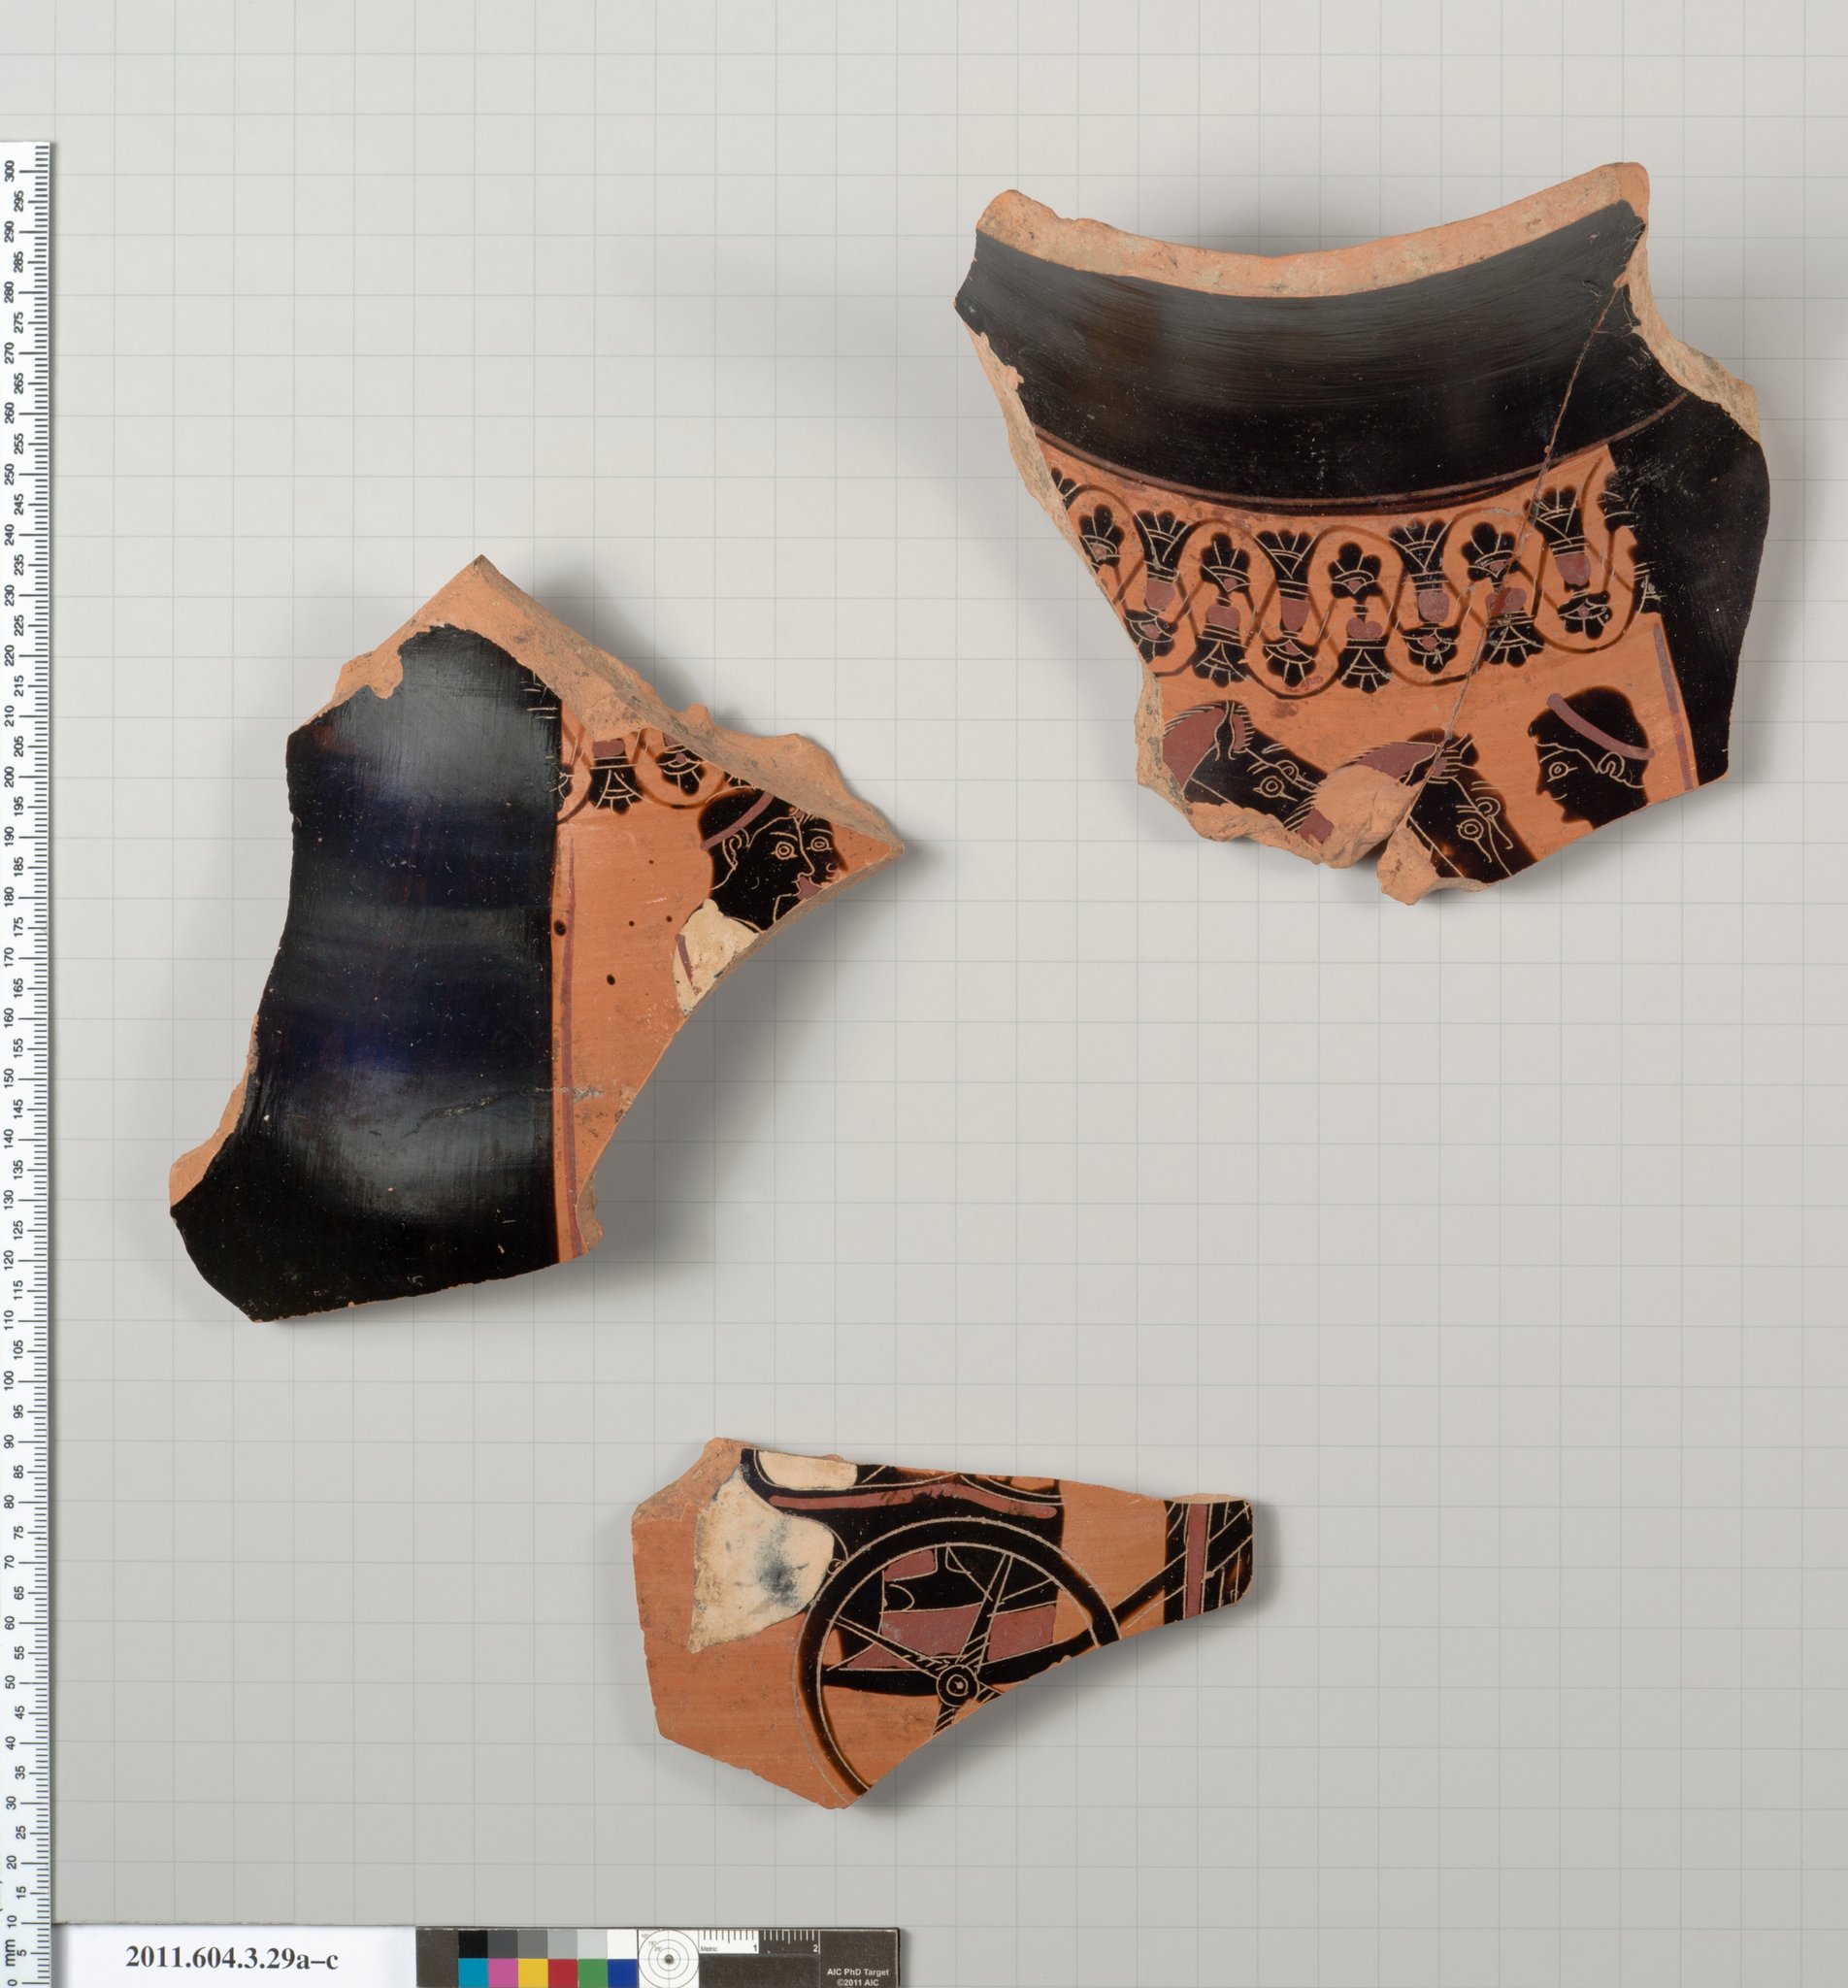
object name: amphora fragment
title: Terracotta fragments of an amphora (jar)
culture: greek, attic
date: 540 BCE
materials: terracotta